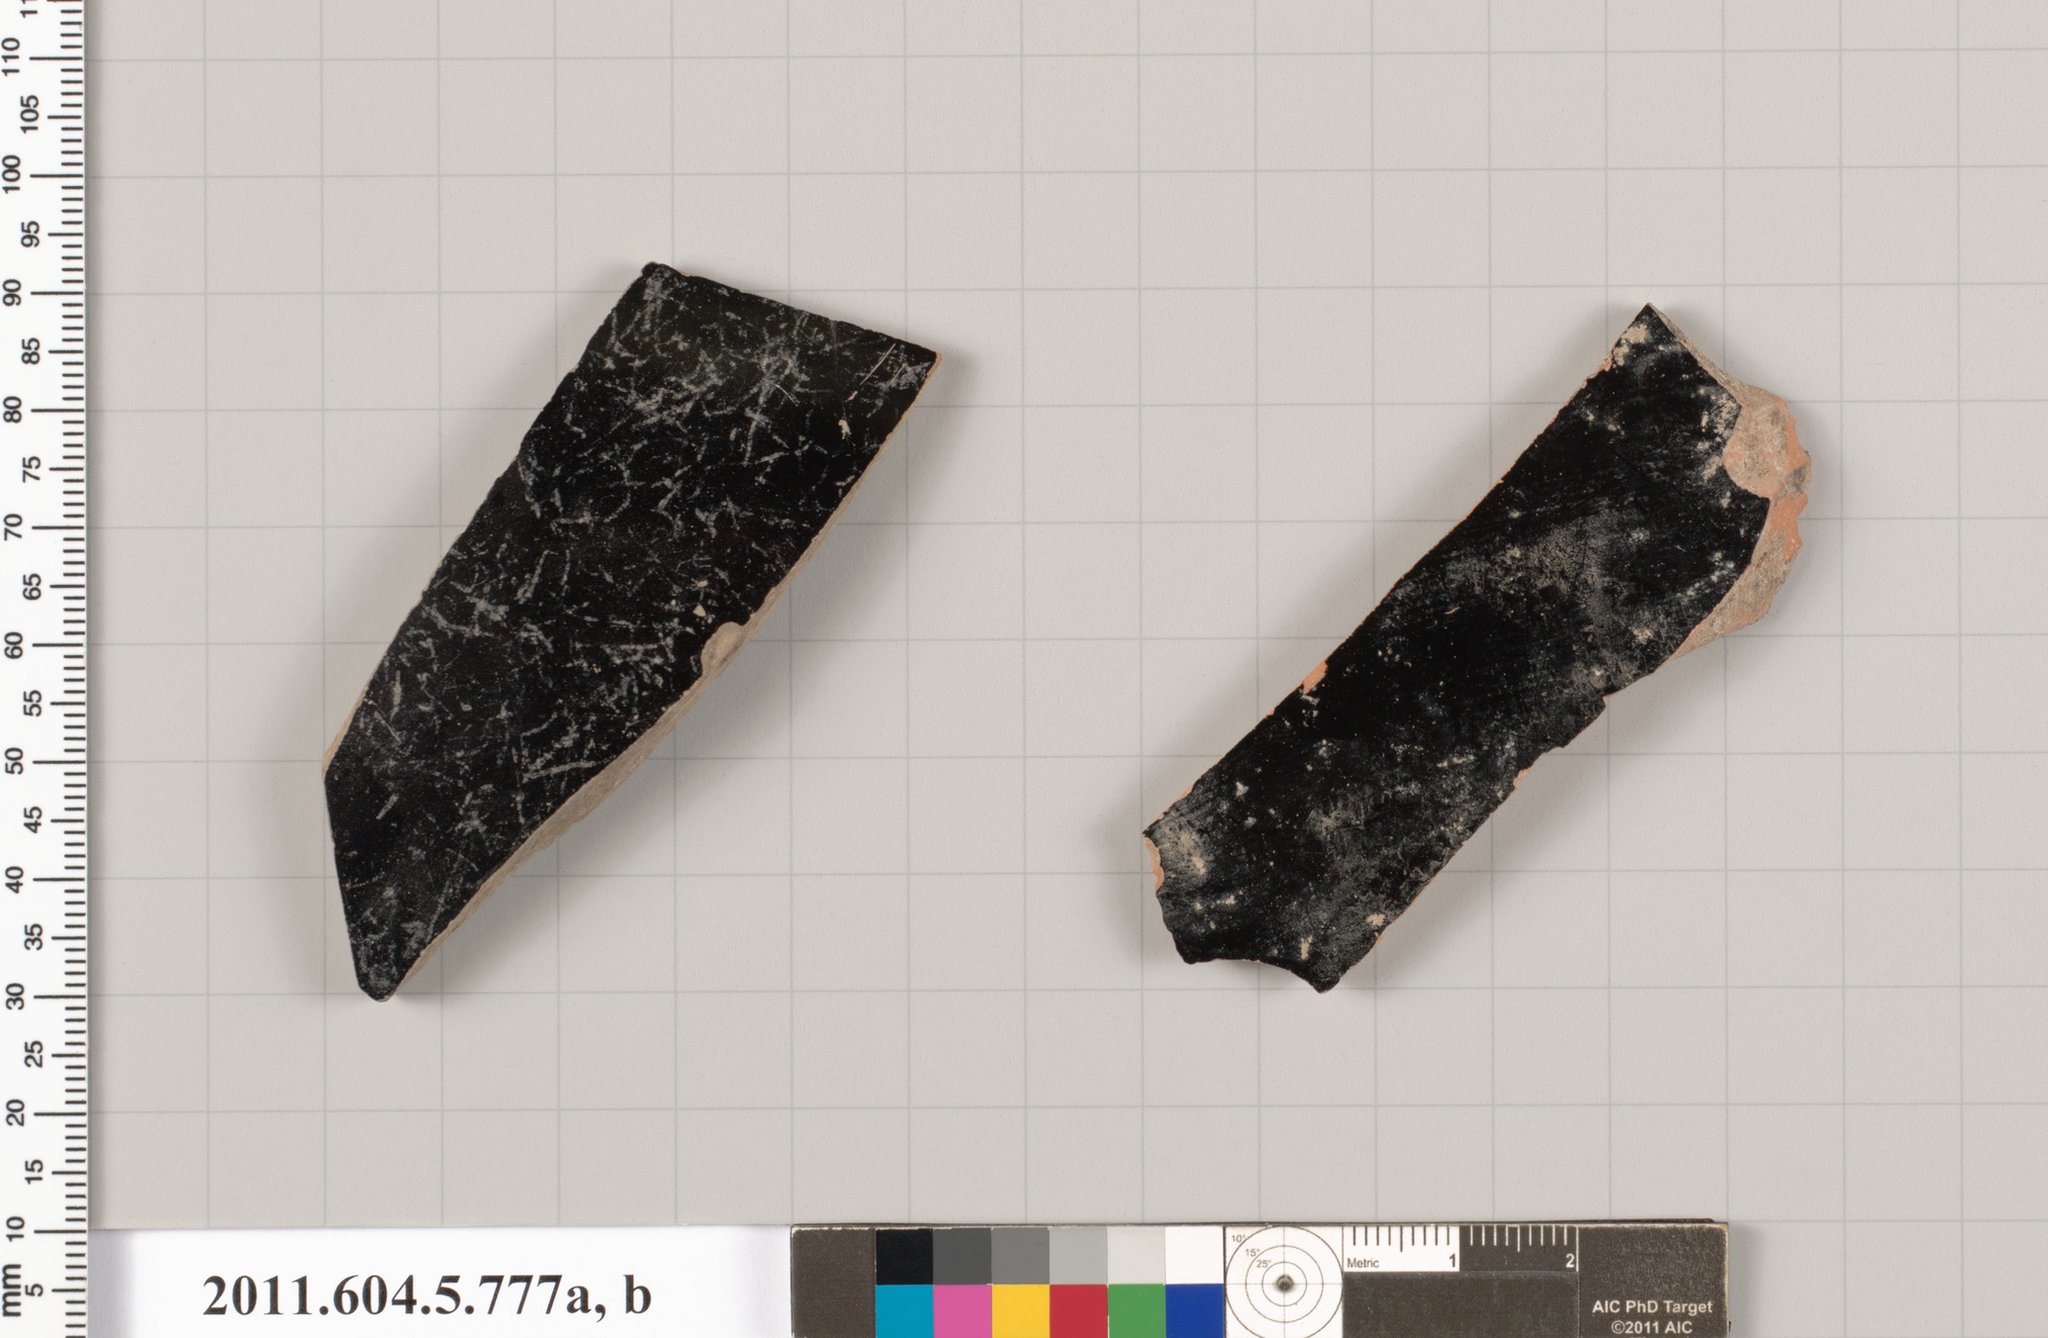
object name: kylix fragment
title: Terracotta fragments of kylikes (drinking cups)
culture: greek, attic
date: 600-401 BCE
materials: terracotta